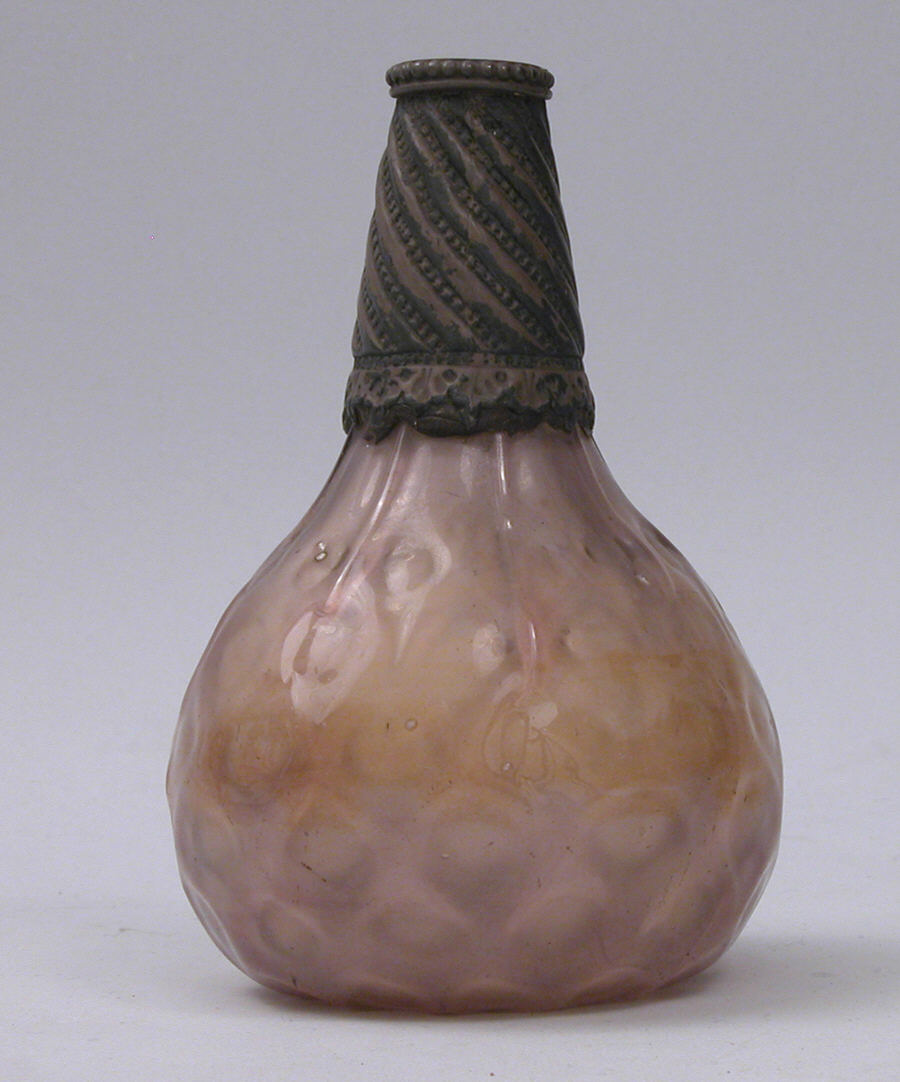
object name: sprinkler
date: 1701-1900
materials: glass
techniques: glassblowing, tooling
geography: india